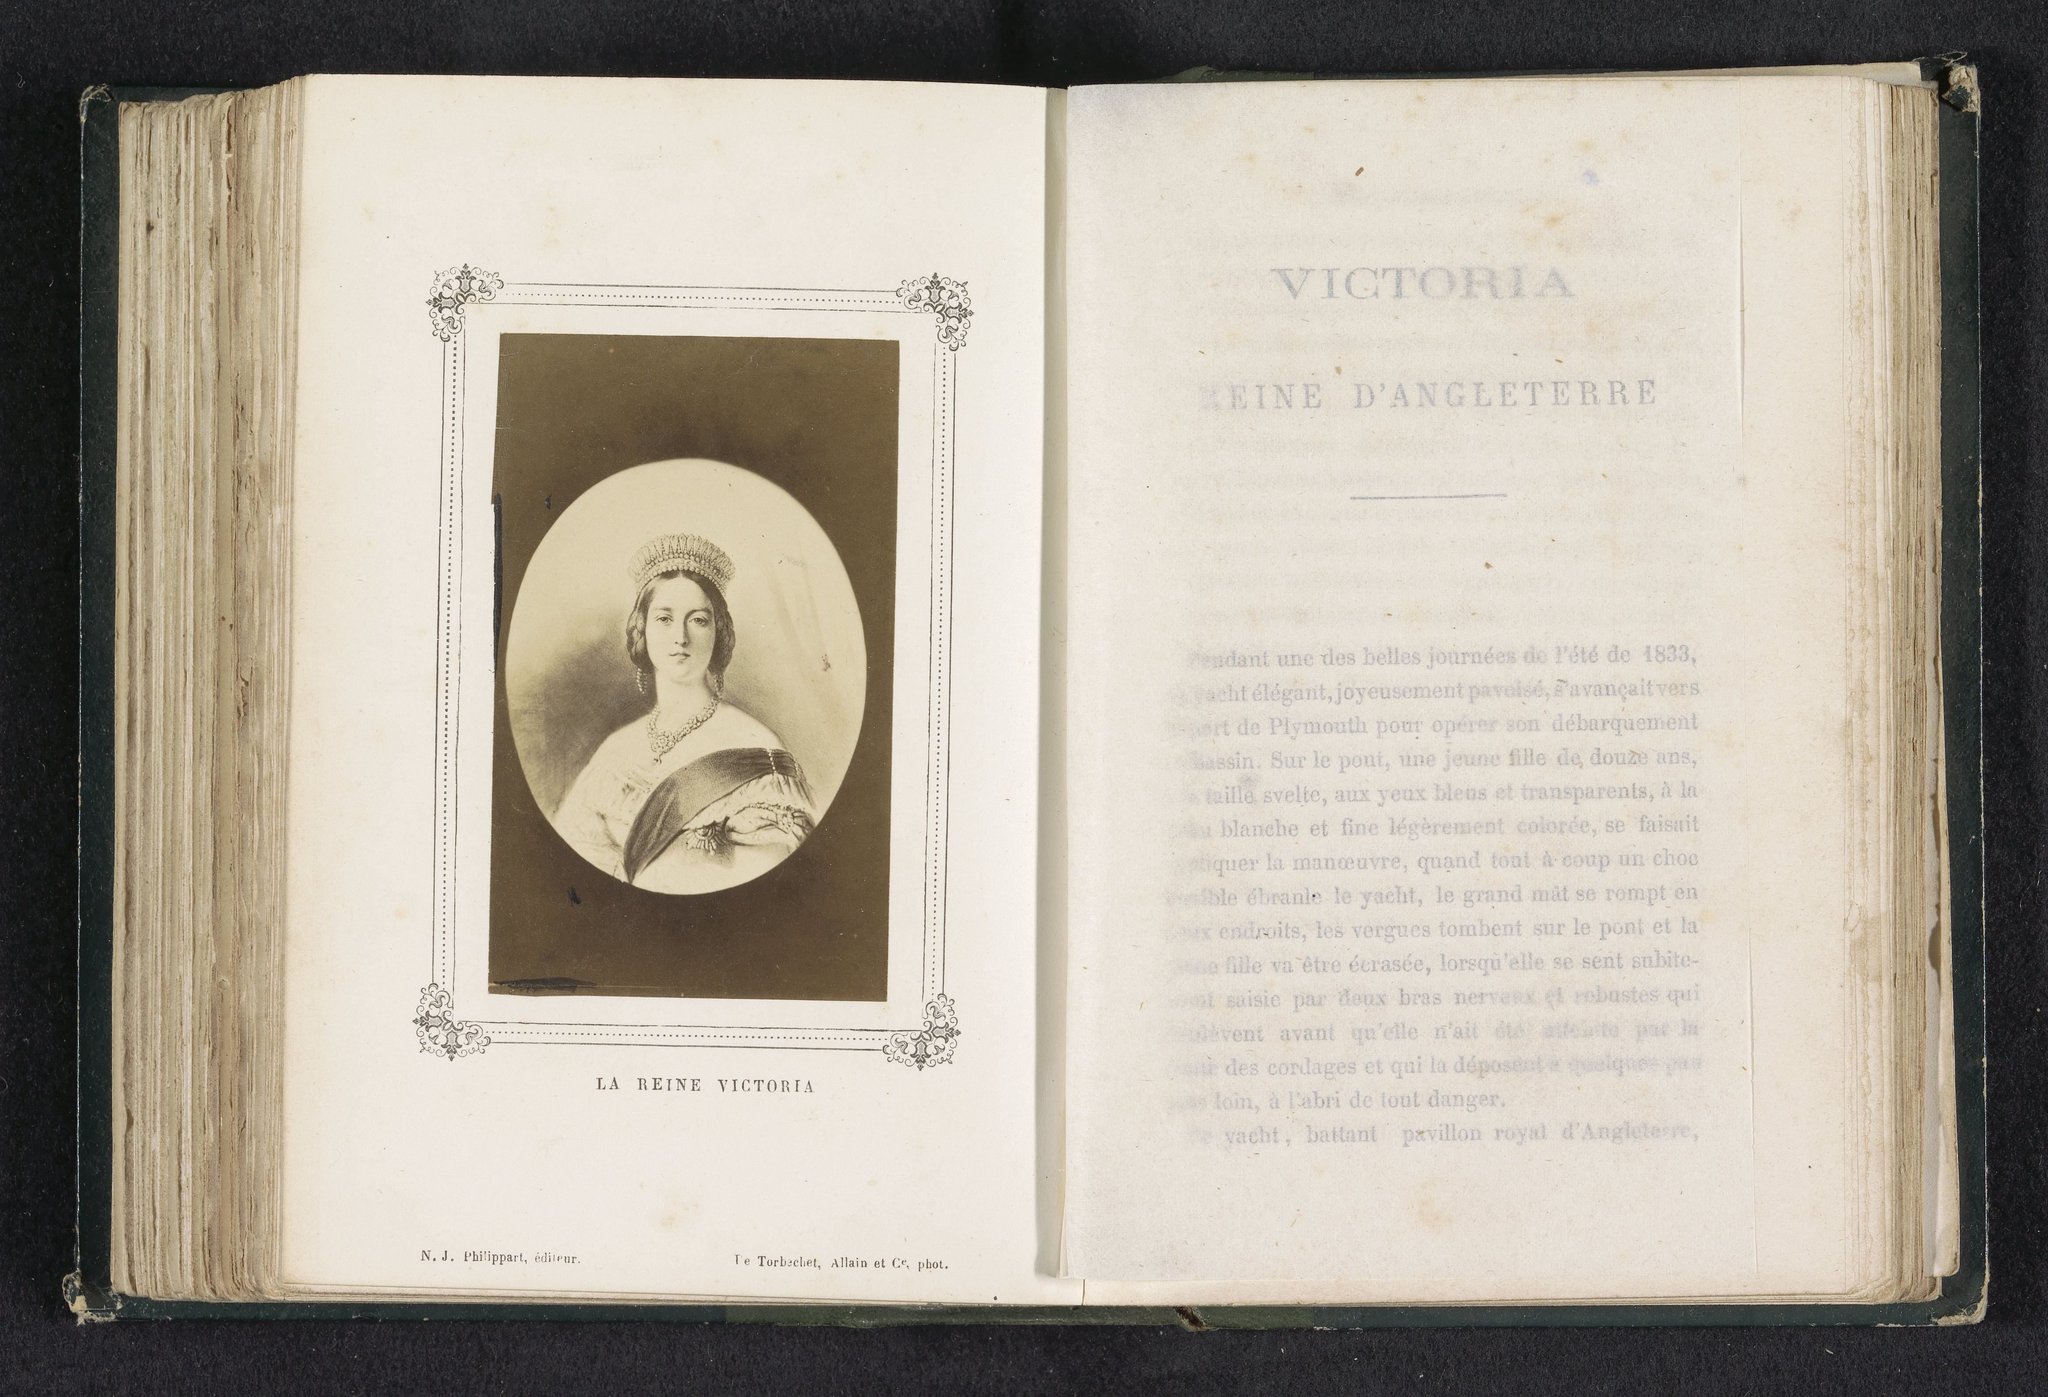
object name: reproduction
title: La reine Victoria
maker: n.-j. philippart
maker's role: publisher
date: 1853-1863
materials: photographic support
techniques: albumen print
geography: paris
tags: victoria (koningin van het verenigd koninkrijk en keizerin van india), ruler, sovereign - bb - female ruler